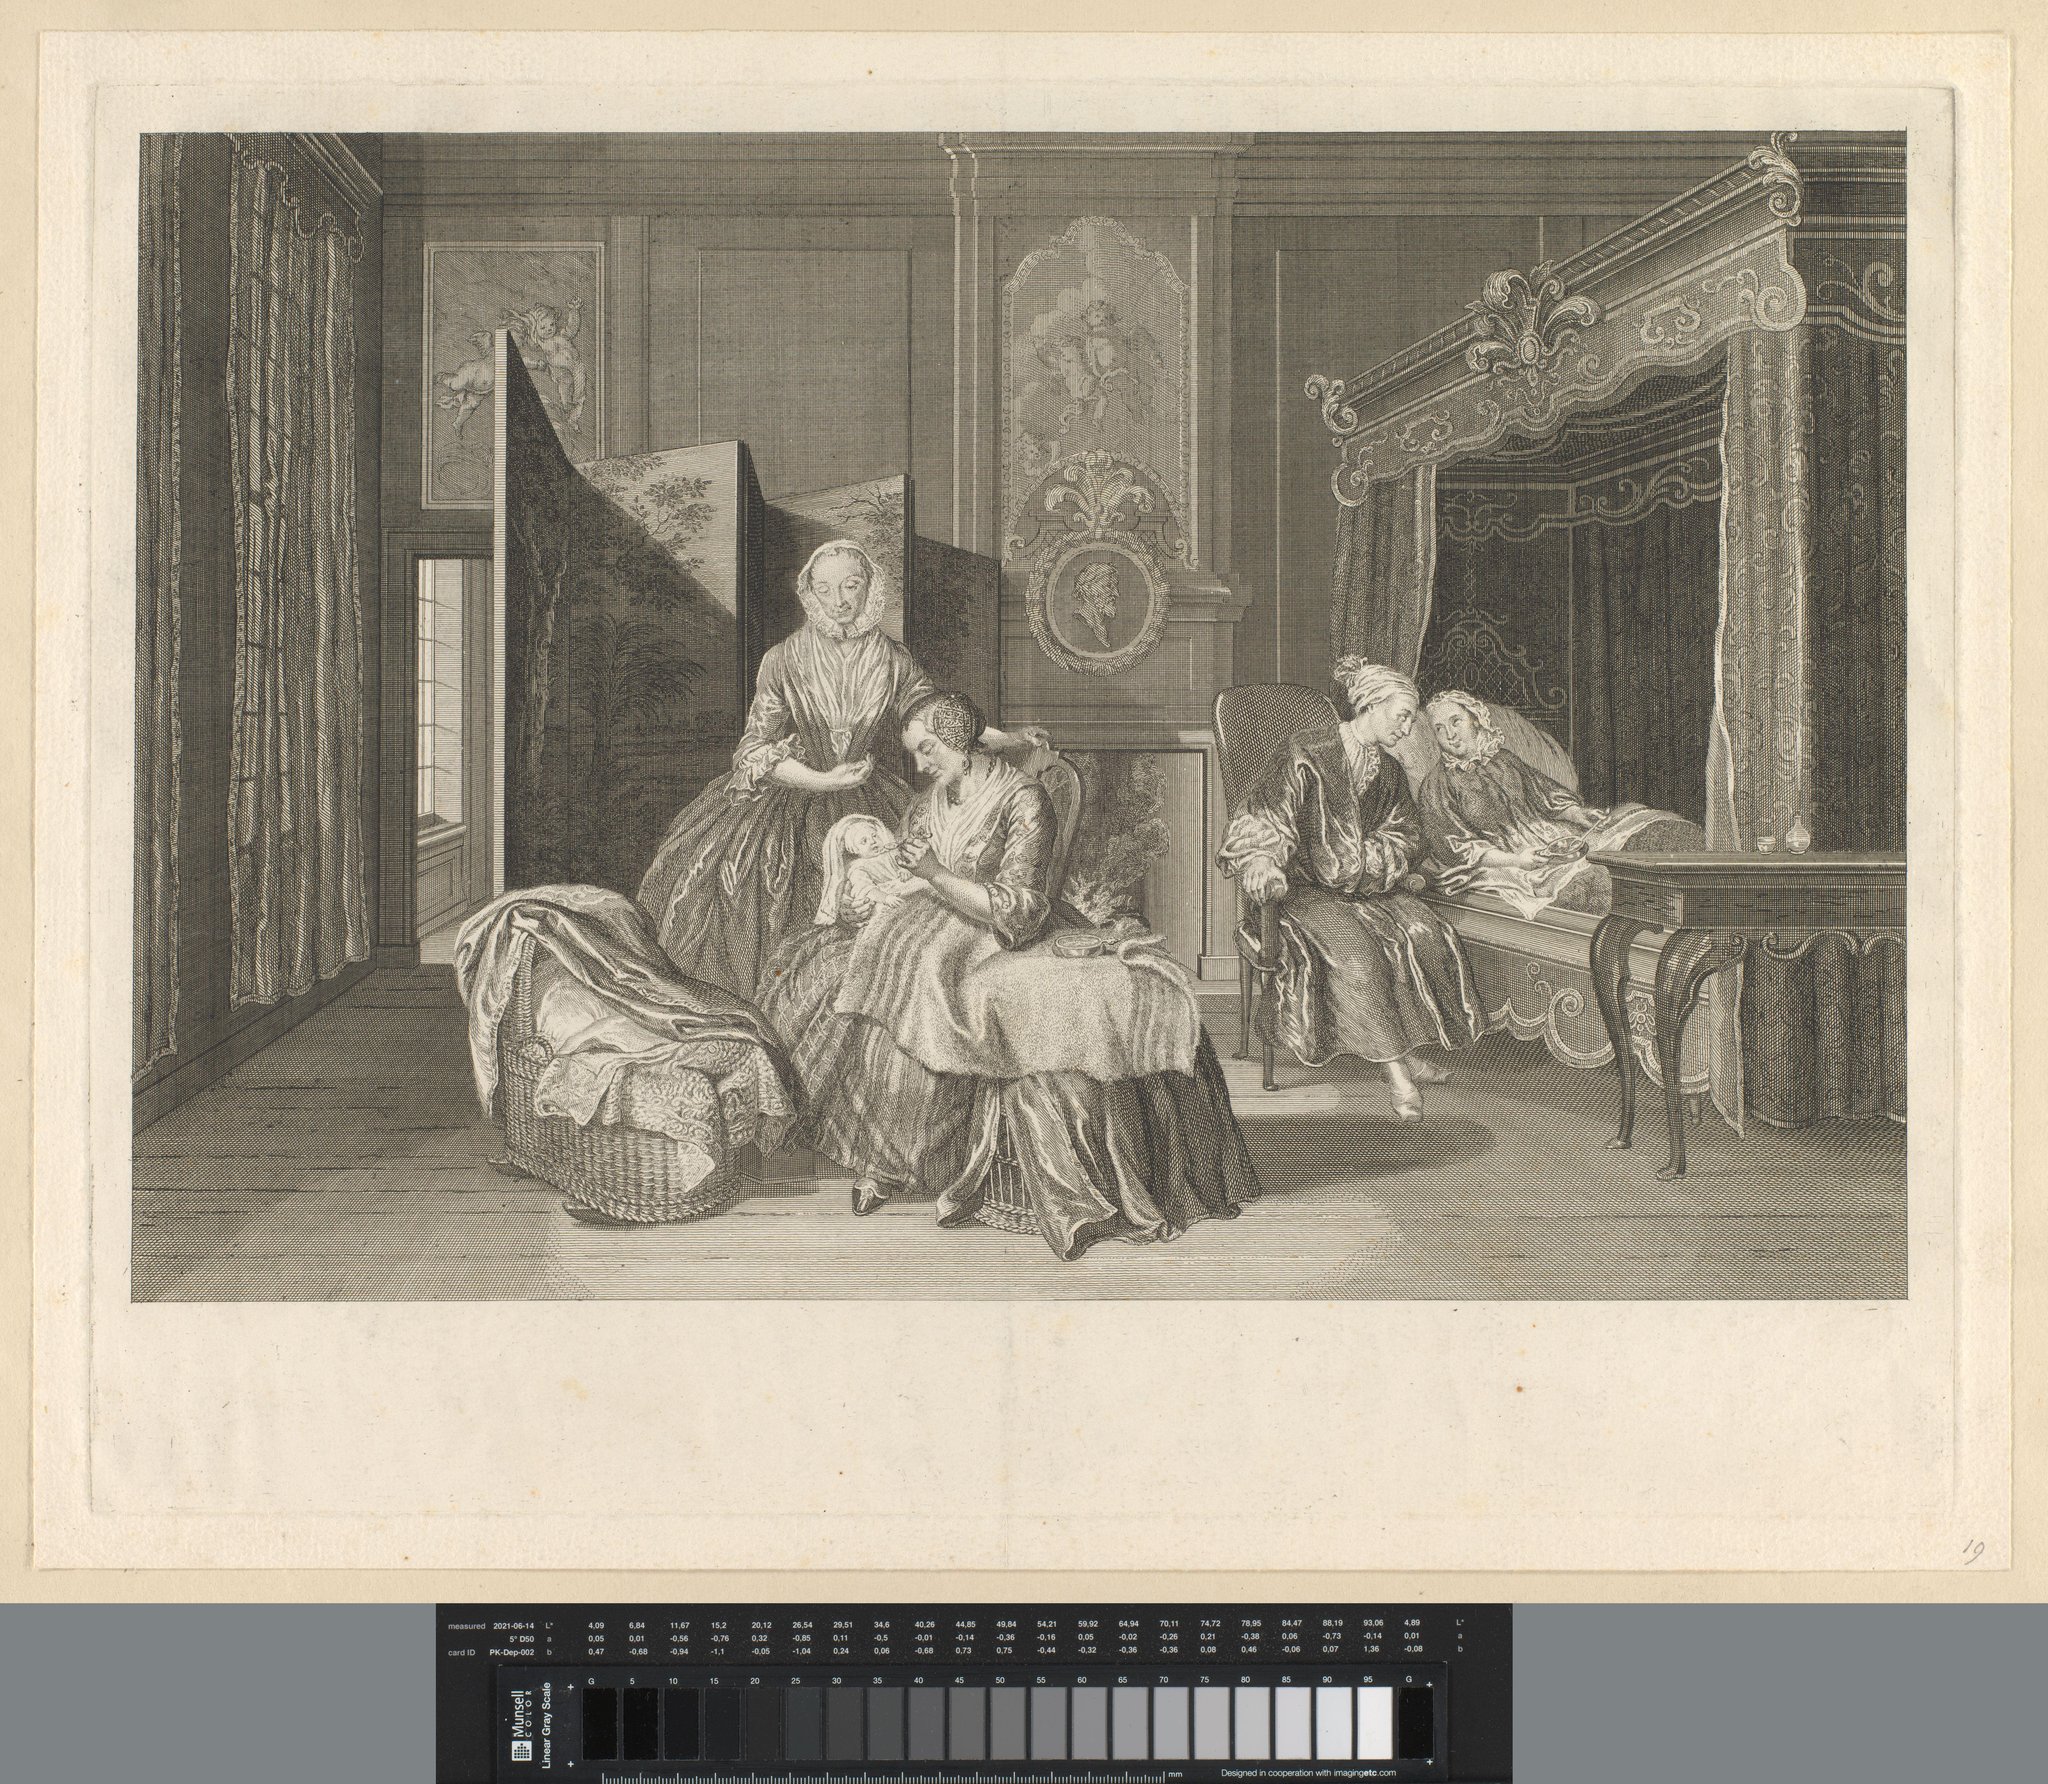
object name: print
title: Hollandse kraamkamer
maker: pieter tanjé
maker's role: draughtsman, print maker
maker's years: 1706-1761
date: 1757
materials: paper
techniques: etching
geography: amsterdam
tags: bed with tester, cradle, crib, lying-in room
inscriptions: collector's mark: Lugt 240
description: In de kraamkamer geeft een min de baby te eten, terwijl een andere vrouw toekijkt. Rechts ligt de moeder in een hemelbed. Naast haar zit haar man.